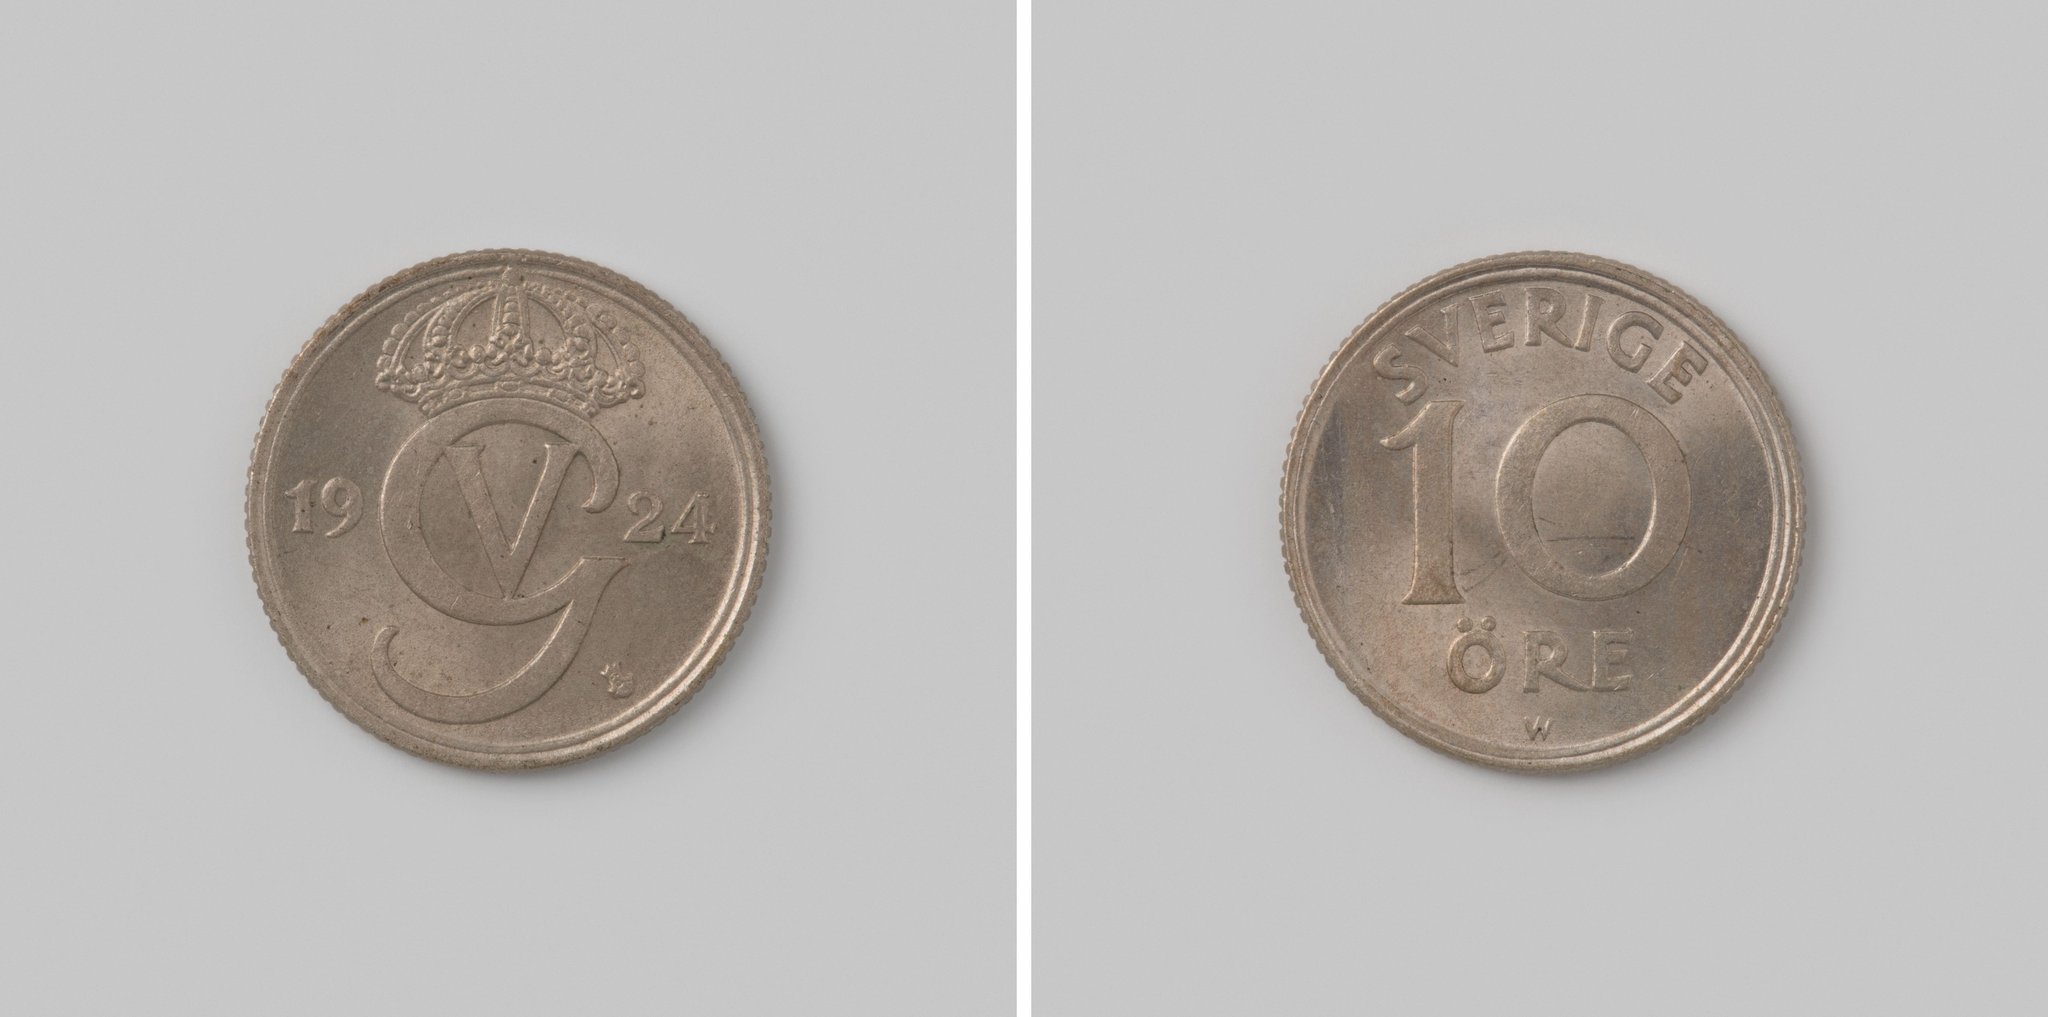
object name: coin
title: 10 öre uit Zweden van Gustav V, 1924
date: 1924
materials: nickel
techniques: striking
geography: slot rörstrand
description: Nikkelen munt. Voorzijde: tussen jaartal monogram van de koning, waarboven koningskroon. Keerzijde: waarde-aanduiding in twee regels. Daaronder jaartal. Gladde rand.